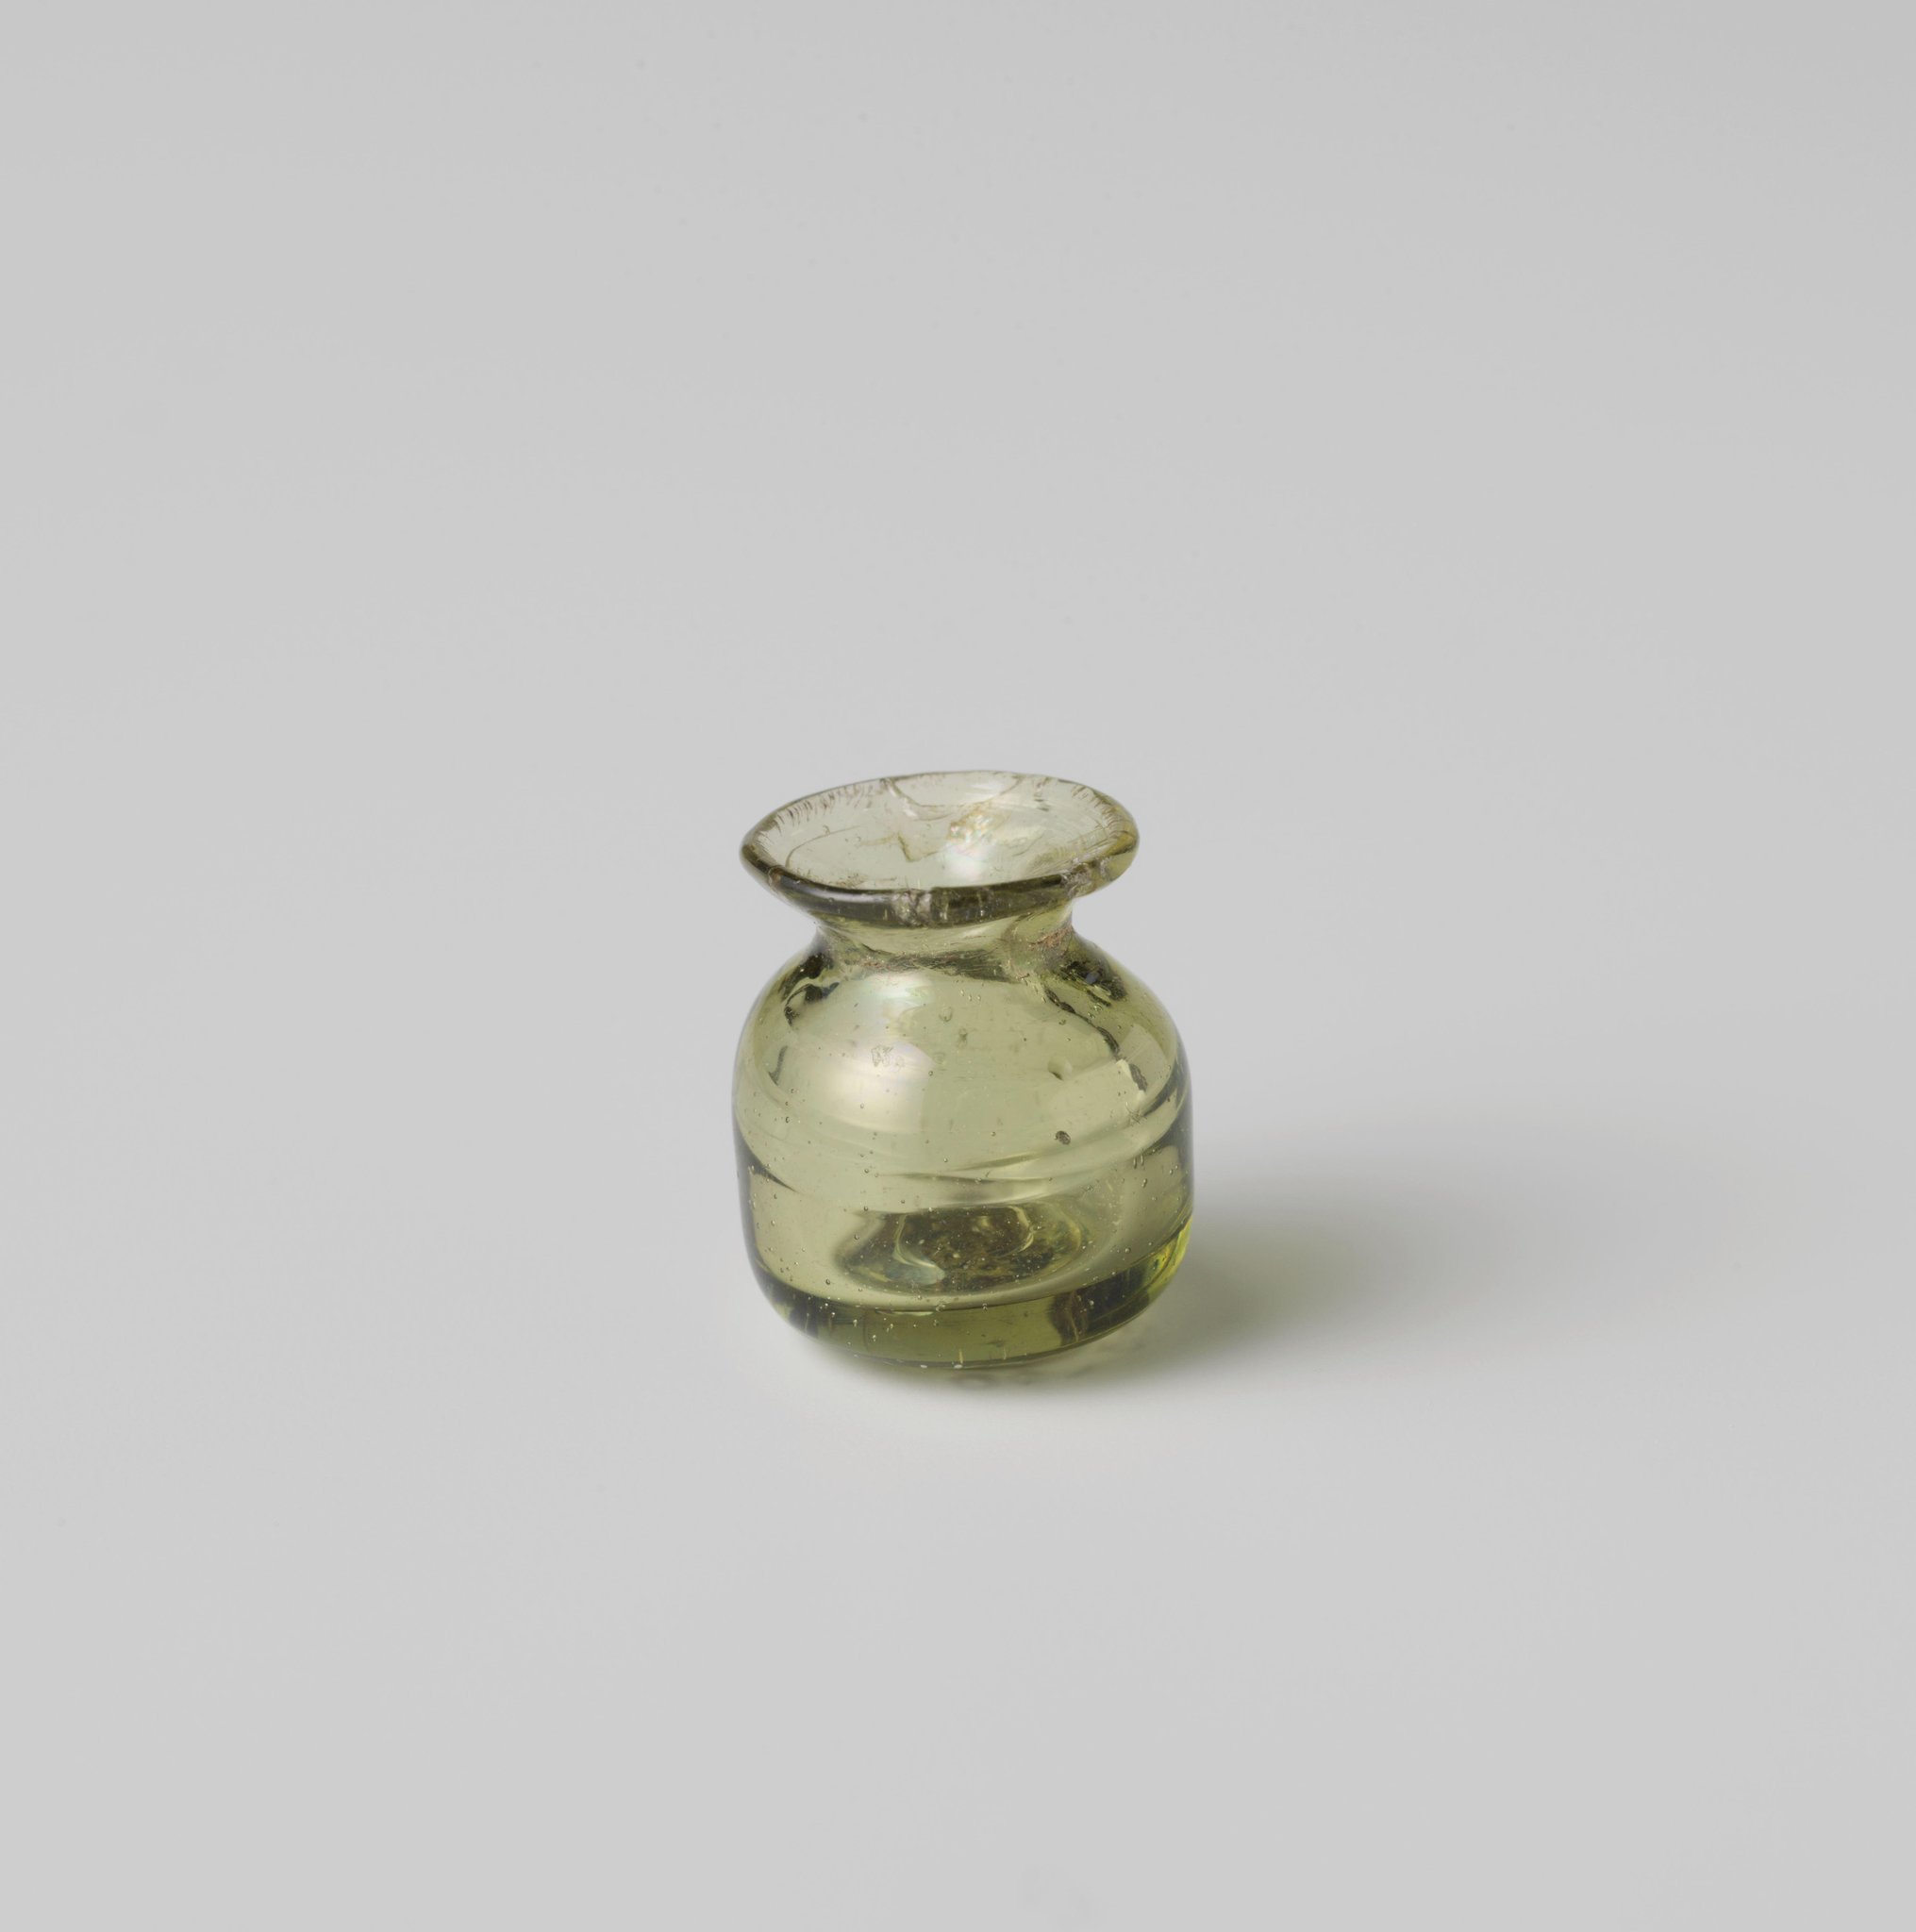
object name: bottle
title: Fles, groen, met ingestoken ziel en uitlopende hals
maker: Anonymous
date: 1700-1799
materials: glass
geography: netherlands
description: Fles van helder groen glas met ingestoken ziel en uitlopende hals.